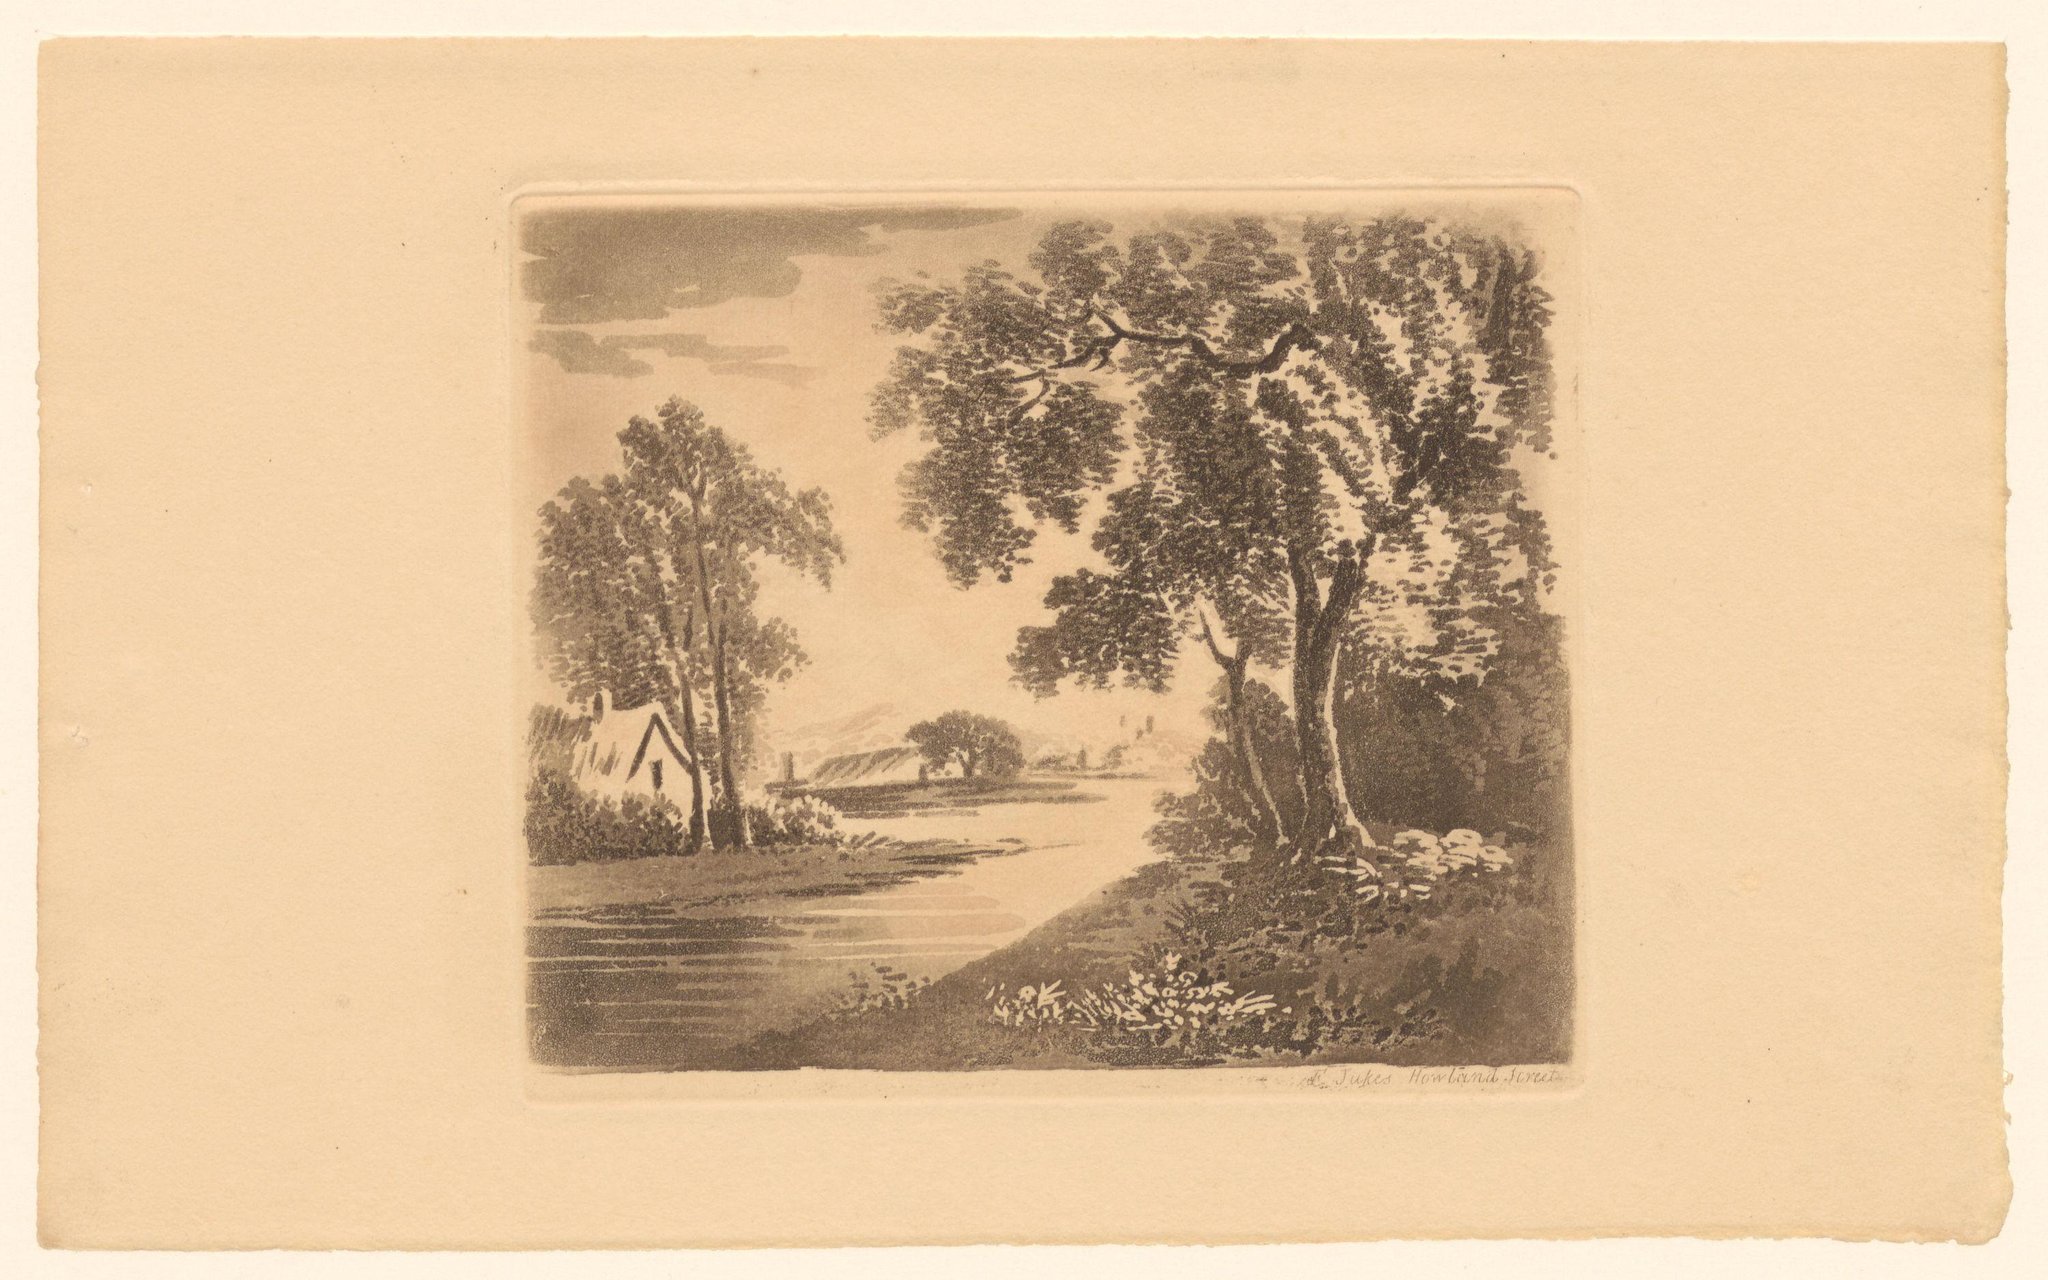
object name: print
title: Landschap met een beek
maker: francis jukes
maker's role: print maker, publisher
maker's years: 1745-1812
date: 1755-1812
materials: paper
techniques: aquatint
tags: water course (+ landscape with figures, staffage)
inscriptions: collector's mark: Lugt 2228